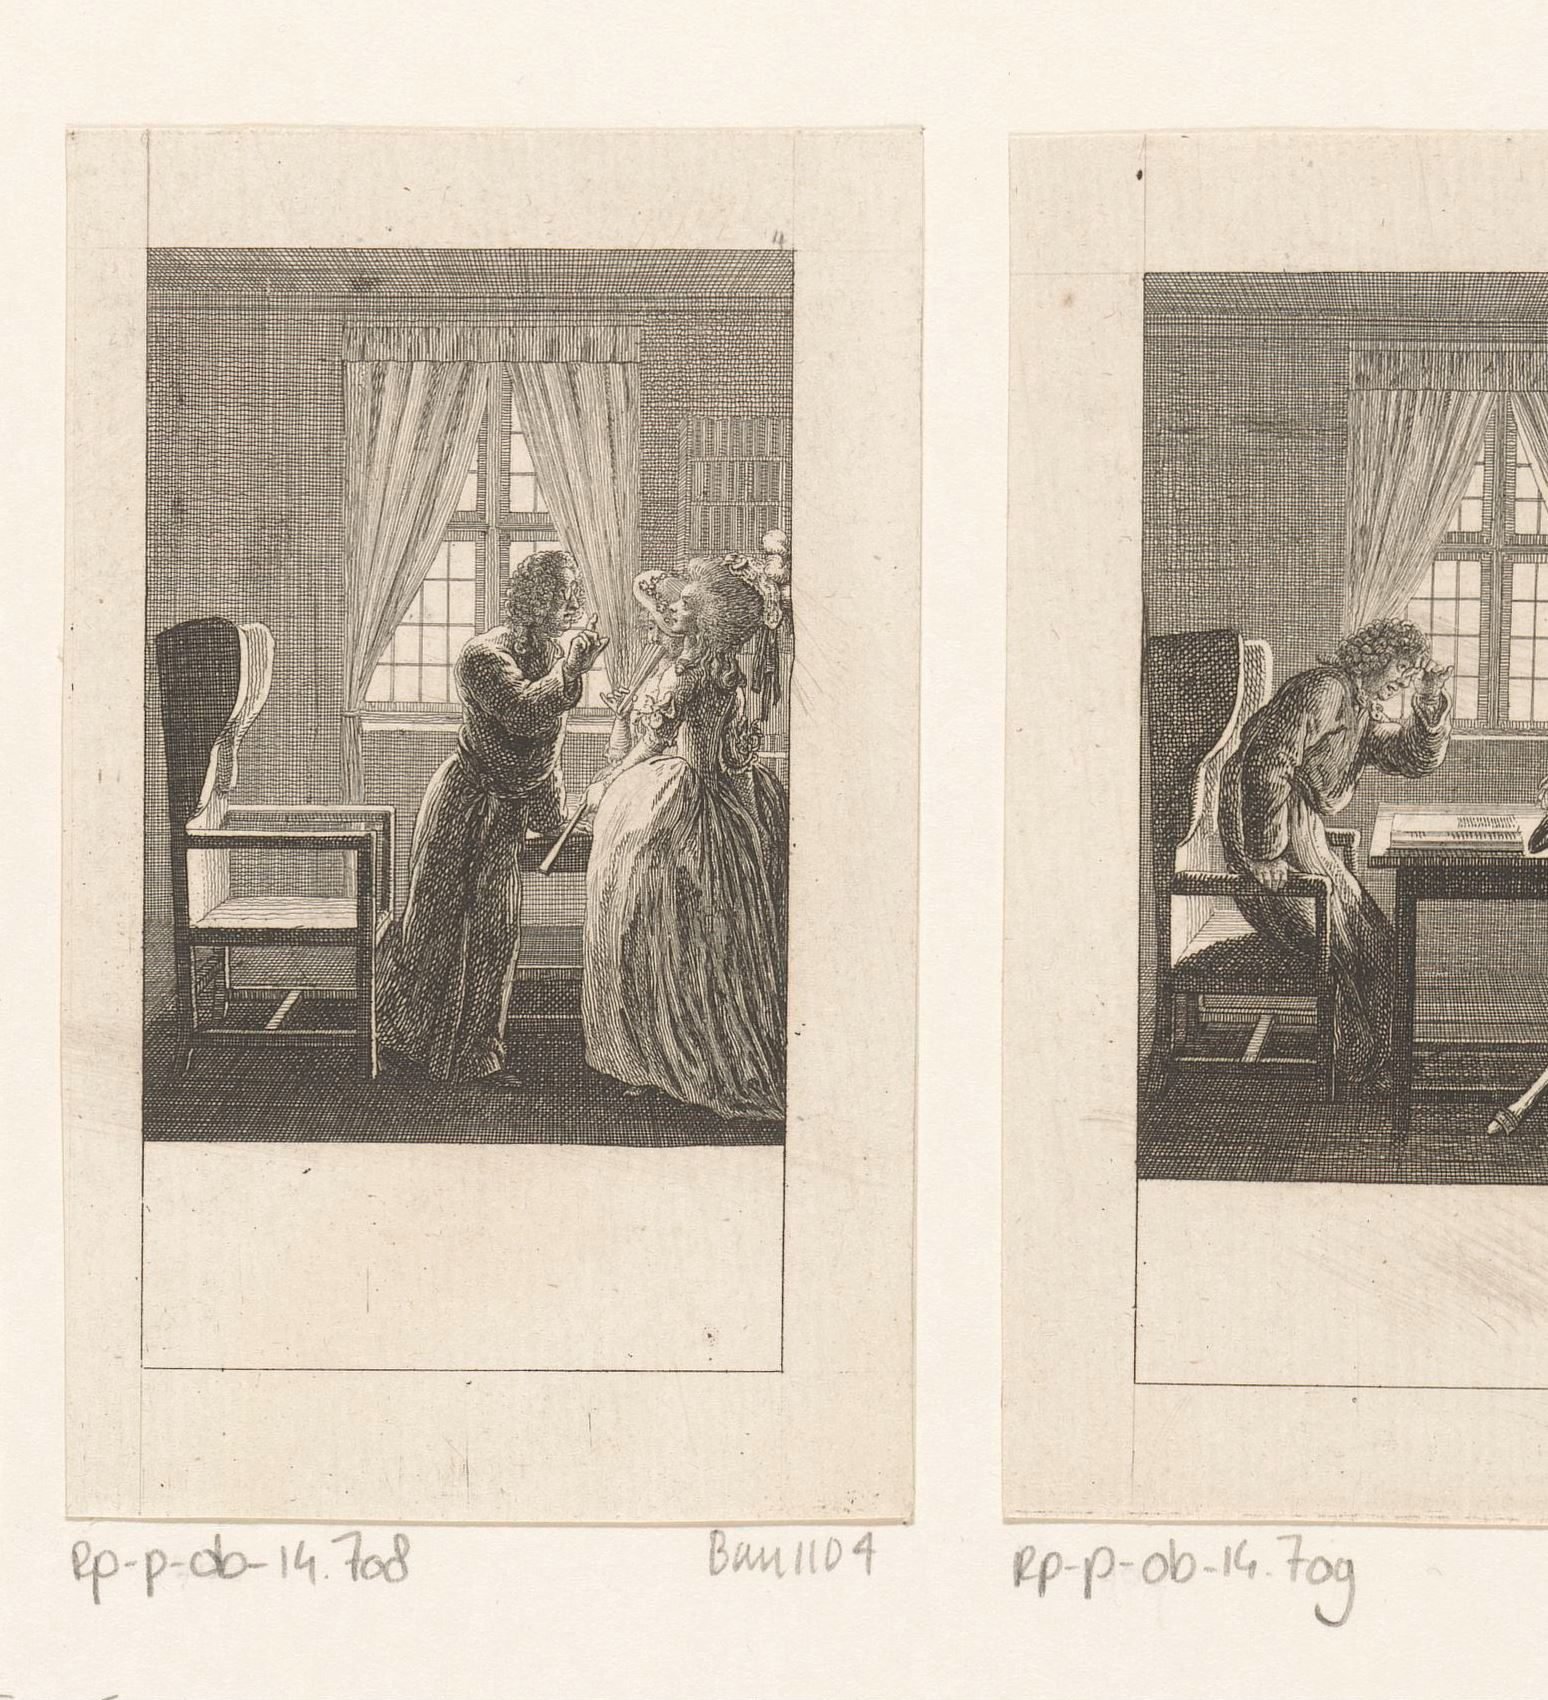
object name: print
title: Charlotte Blunt en Olympia Wintergrün in conflict met Storr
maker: daniel nikolaus chodowiecki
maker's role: draughtsman, print maker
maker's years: 1726-1801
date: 1784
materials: paper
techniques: etching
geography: berlin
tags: literature, book-keeping, accountant, conversation, dialogue; conversation piece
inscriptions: collector's mark: Lugt 2228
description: Vervaardigd voor Christian Friedrich Bretzners 'Eheprocurator'. Latere staat gebruikt voor: Konigl. Grosbrit. Genealogischen Kalender auf das Jahr 1785. Lauenburg: J. G. Berenberg, 1784.